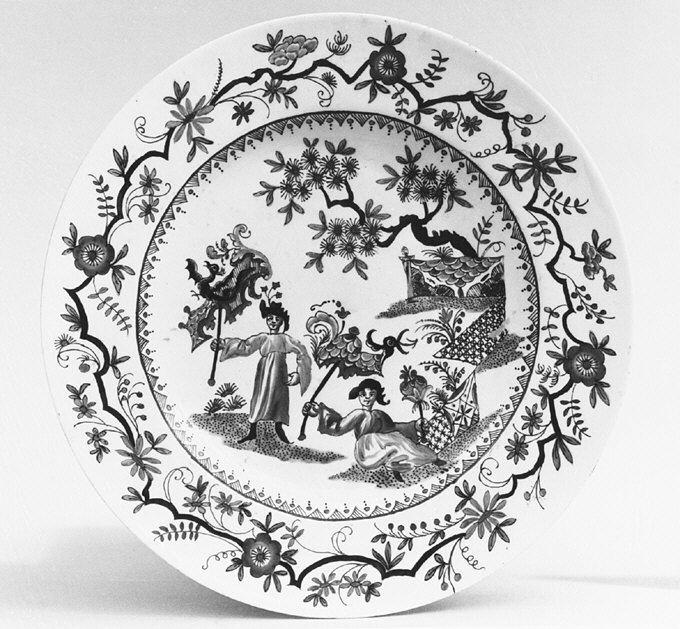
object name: plate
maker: meissen manufactory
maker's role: manufactory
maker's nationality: german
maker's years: 1710-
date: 1725-1730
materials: hard paste porcelain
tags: human figures,flowers